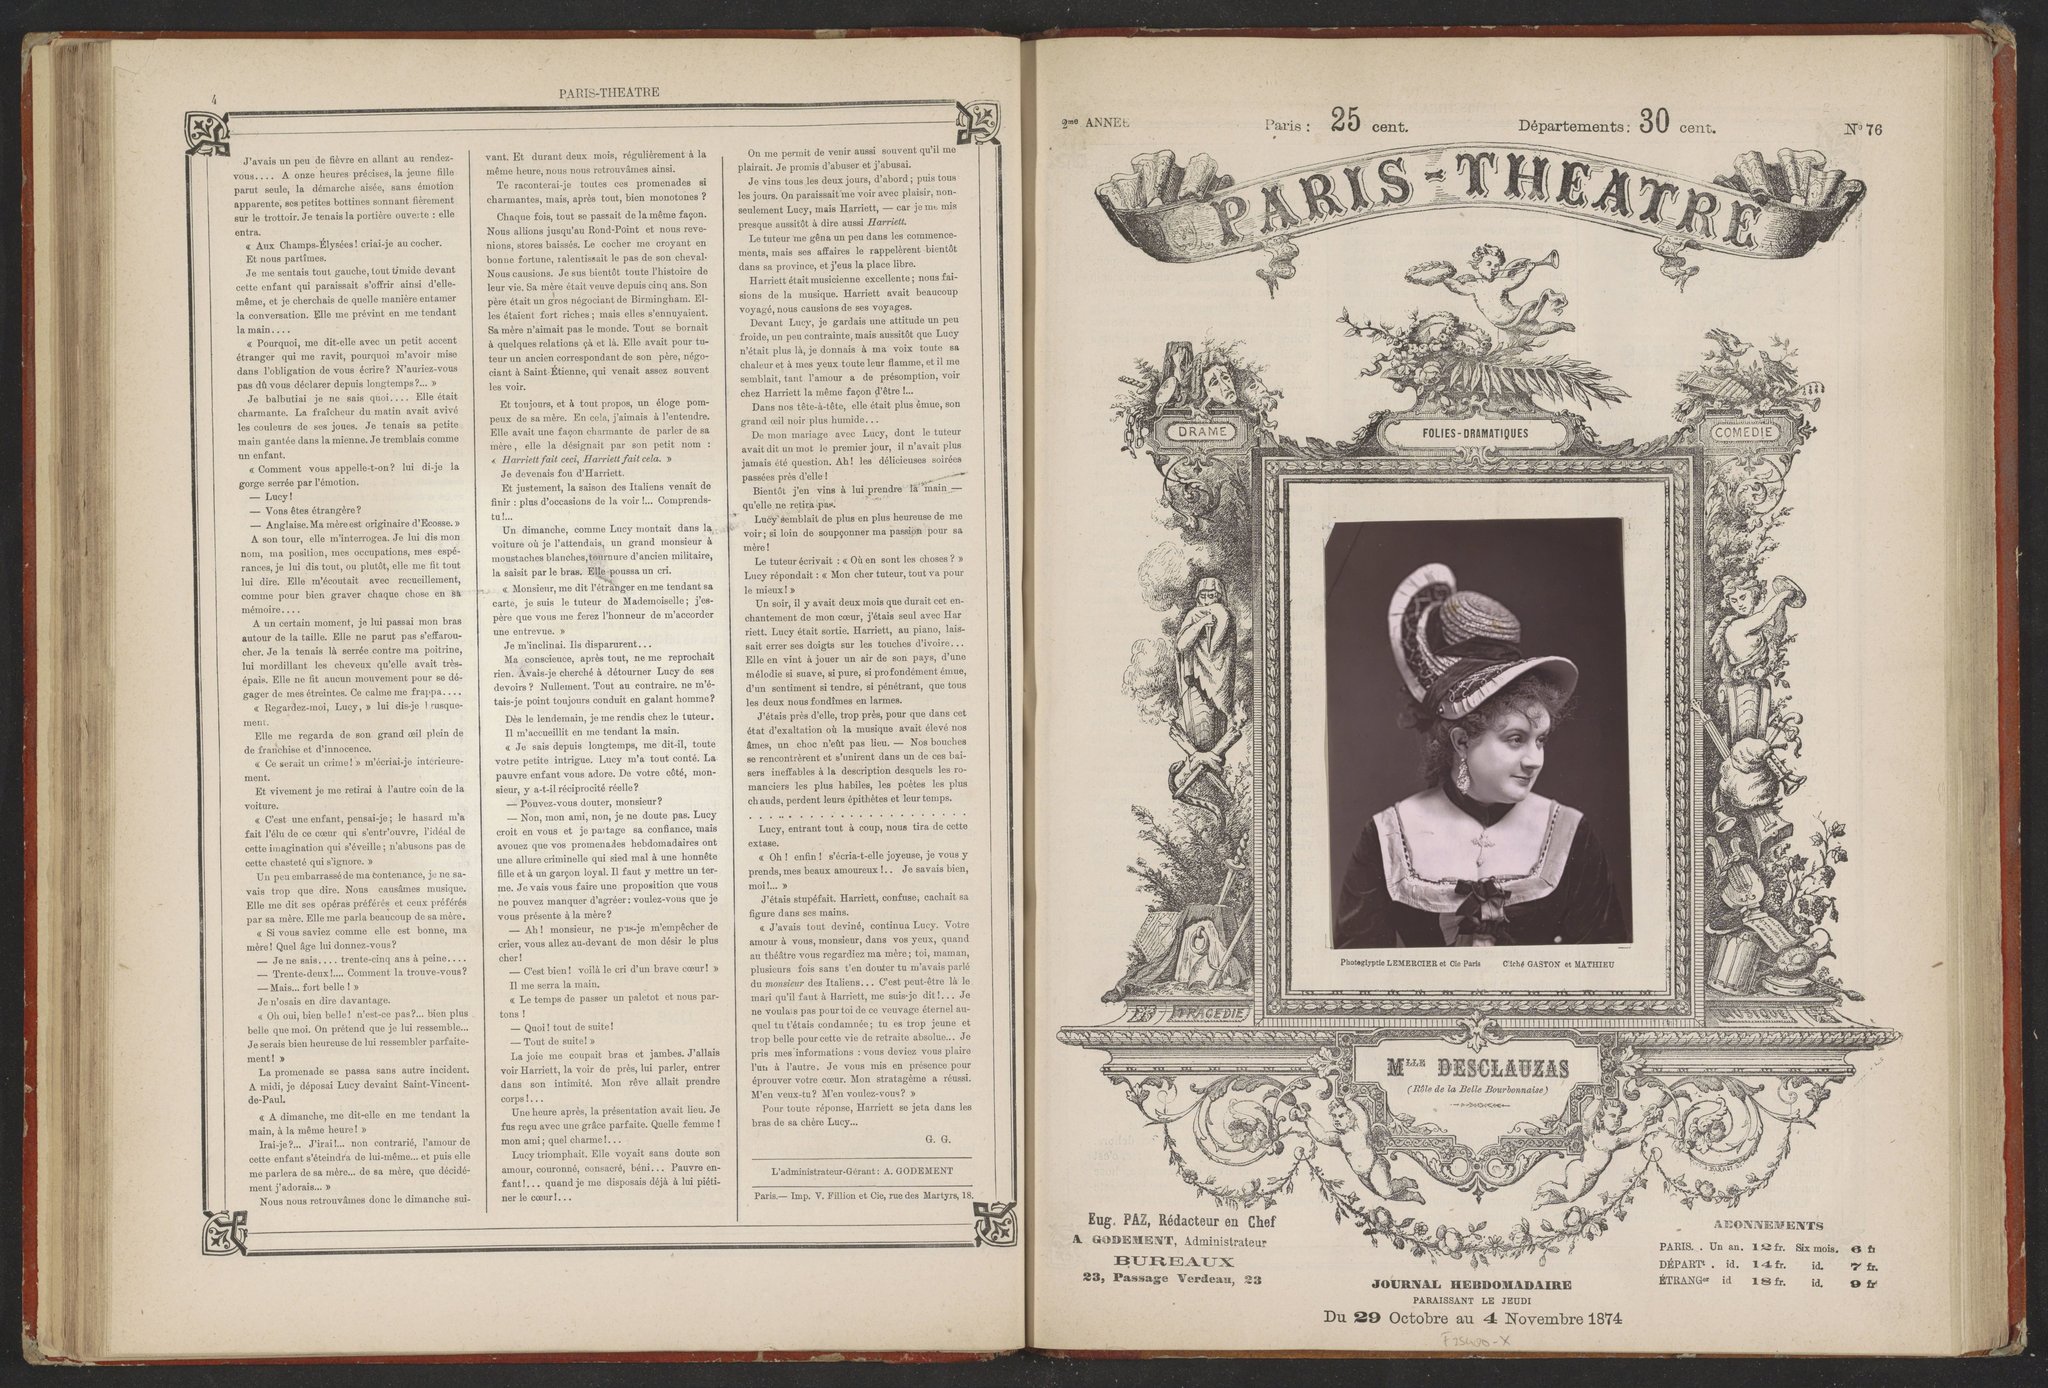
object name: page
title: Mlle Desclauzas (Rôle de la Belle Bourbonnaise)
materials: paper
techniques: woodburytype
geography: france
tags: portrait of actor, actress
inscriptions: inscription: ‘Journal hebdomadaire paraissant le jeudi Du 29 Octobre au 4 Novembre 1874’, number: ‘No 76’